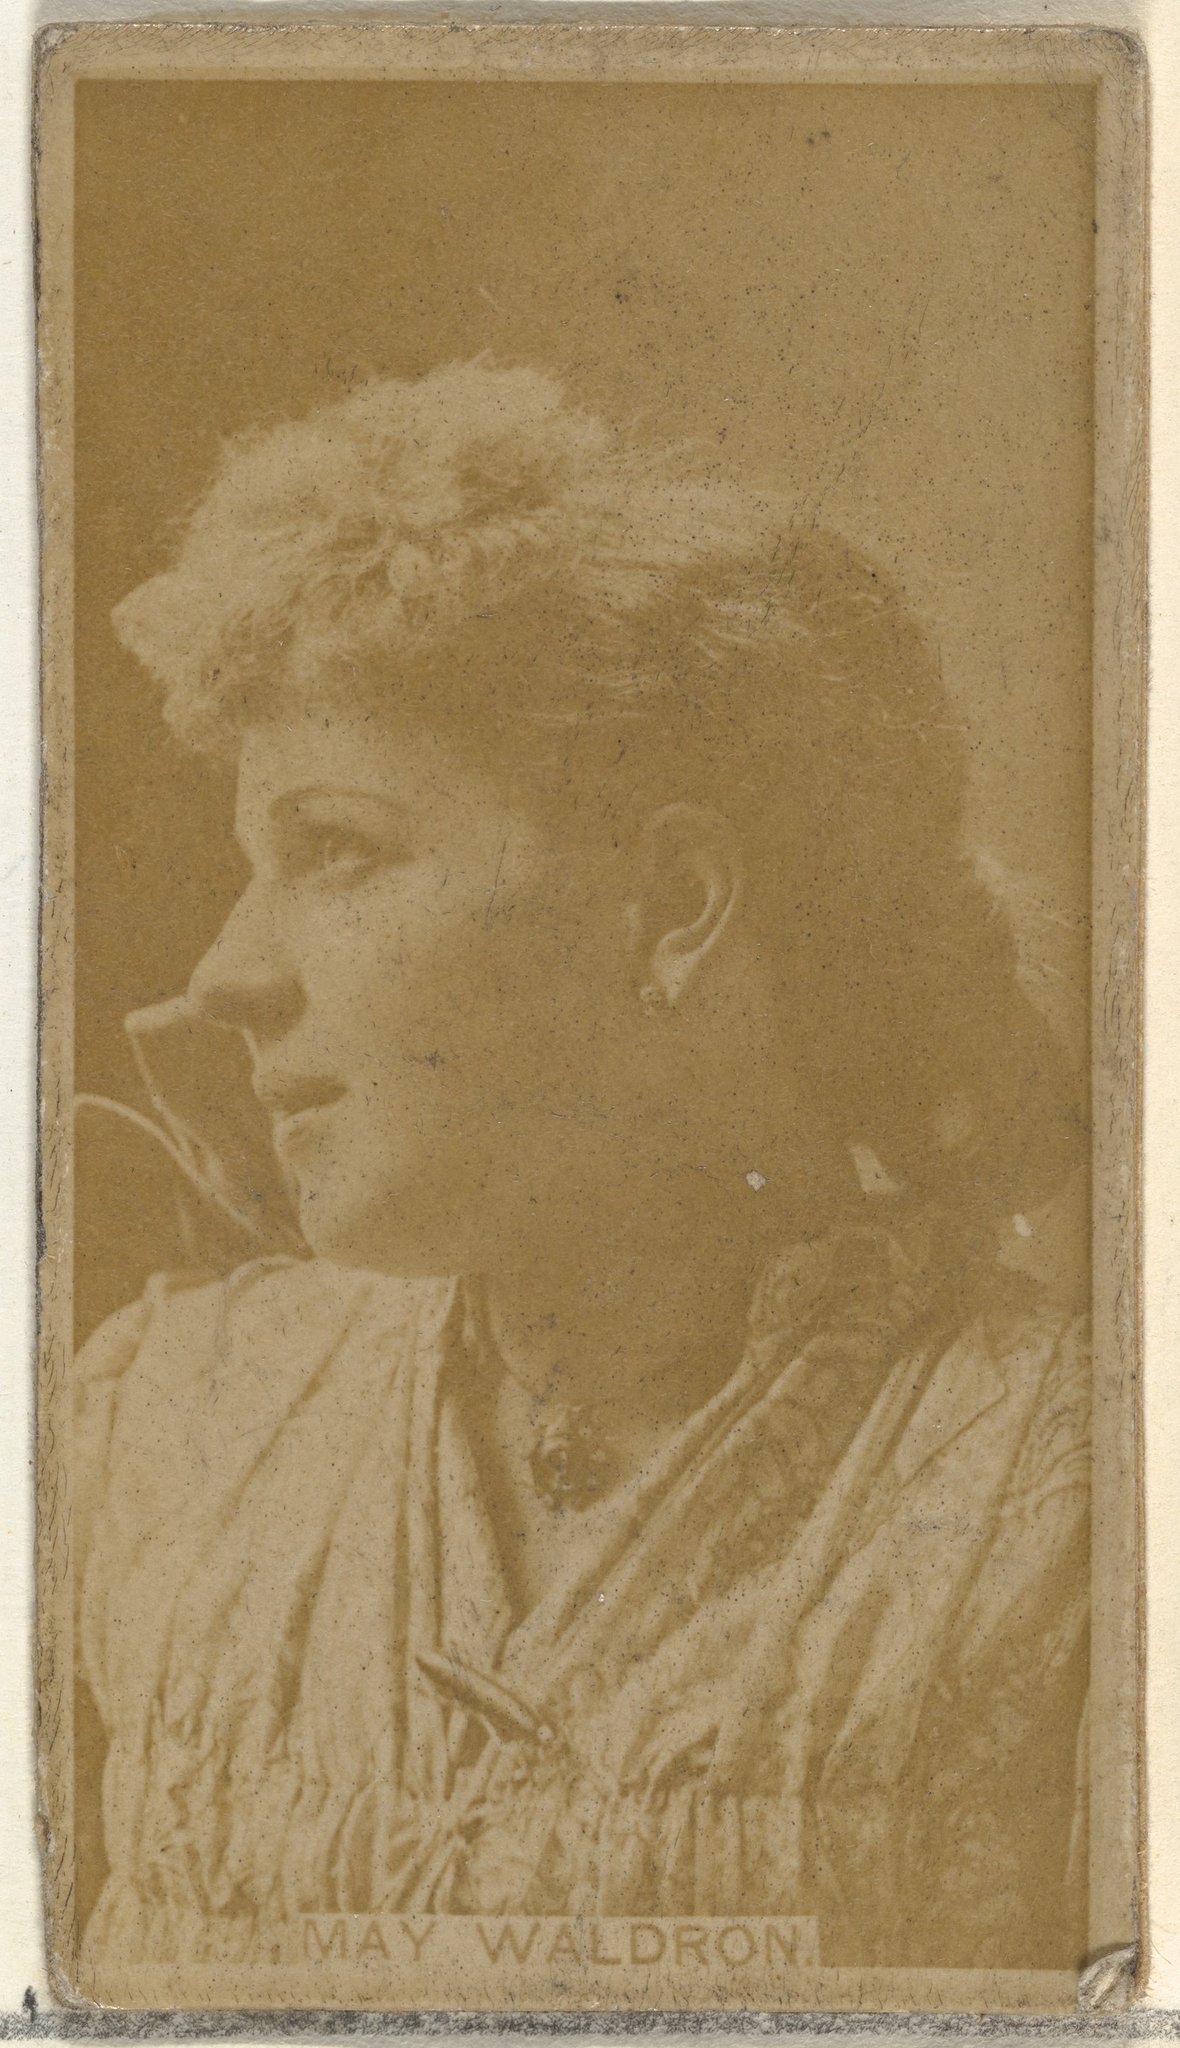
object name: photograph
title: May Waldron, from the Actors and Actresses series (N145-8) issued by Duke Sons & Co. to promote Duke Cigarettes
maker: w. duke, sons & co.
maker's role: publisher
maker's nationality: american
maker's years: 1870-1920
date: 1891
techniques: albumen silver print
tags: portraits,women,actresses